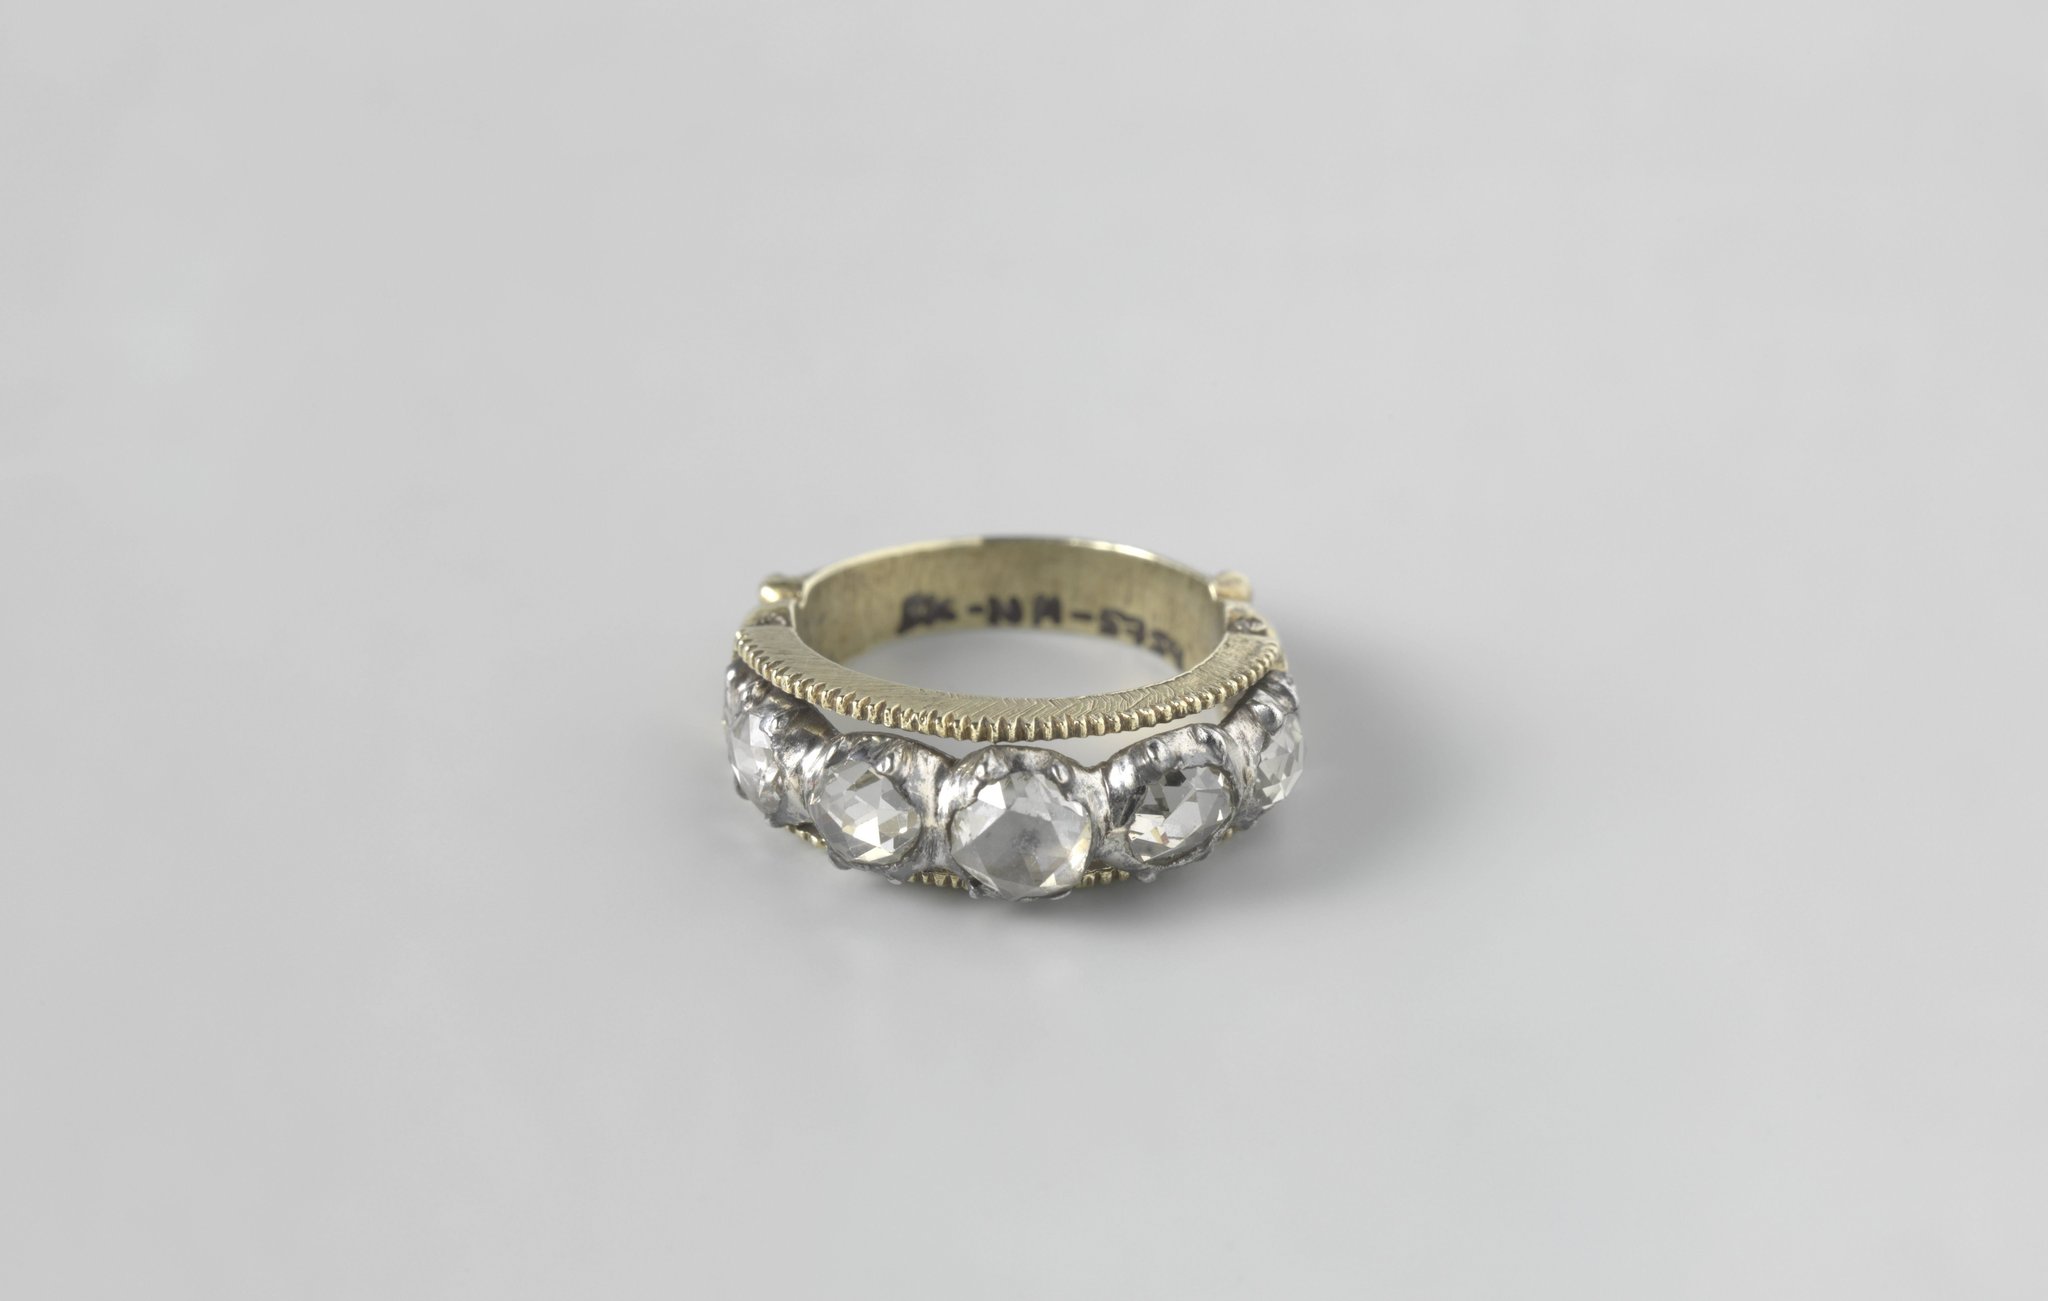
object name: jewellery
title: Ring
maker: Anonymous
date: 1700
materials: diamond, silver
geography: netherlands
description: Ring van zilver. Met vijf stenen naast elkaar.